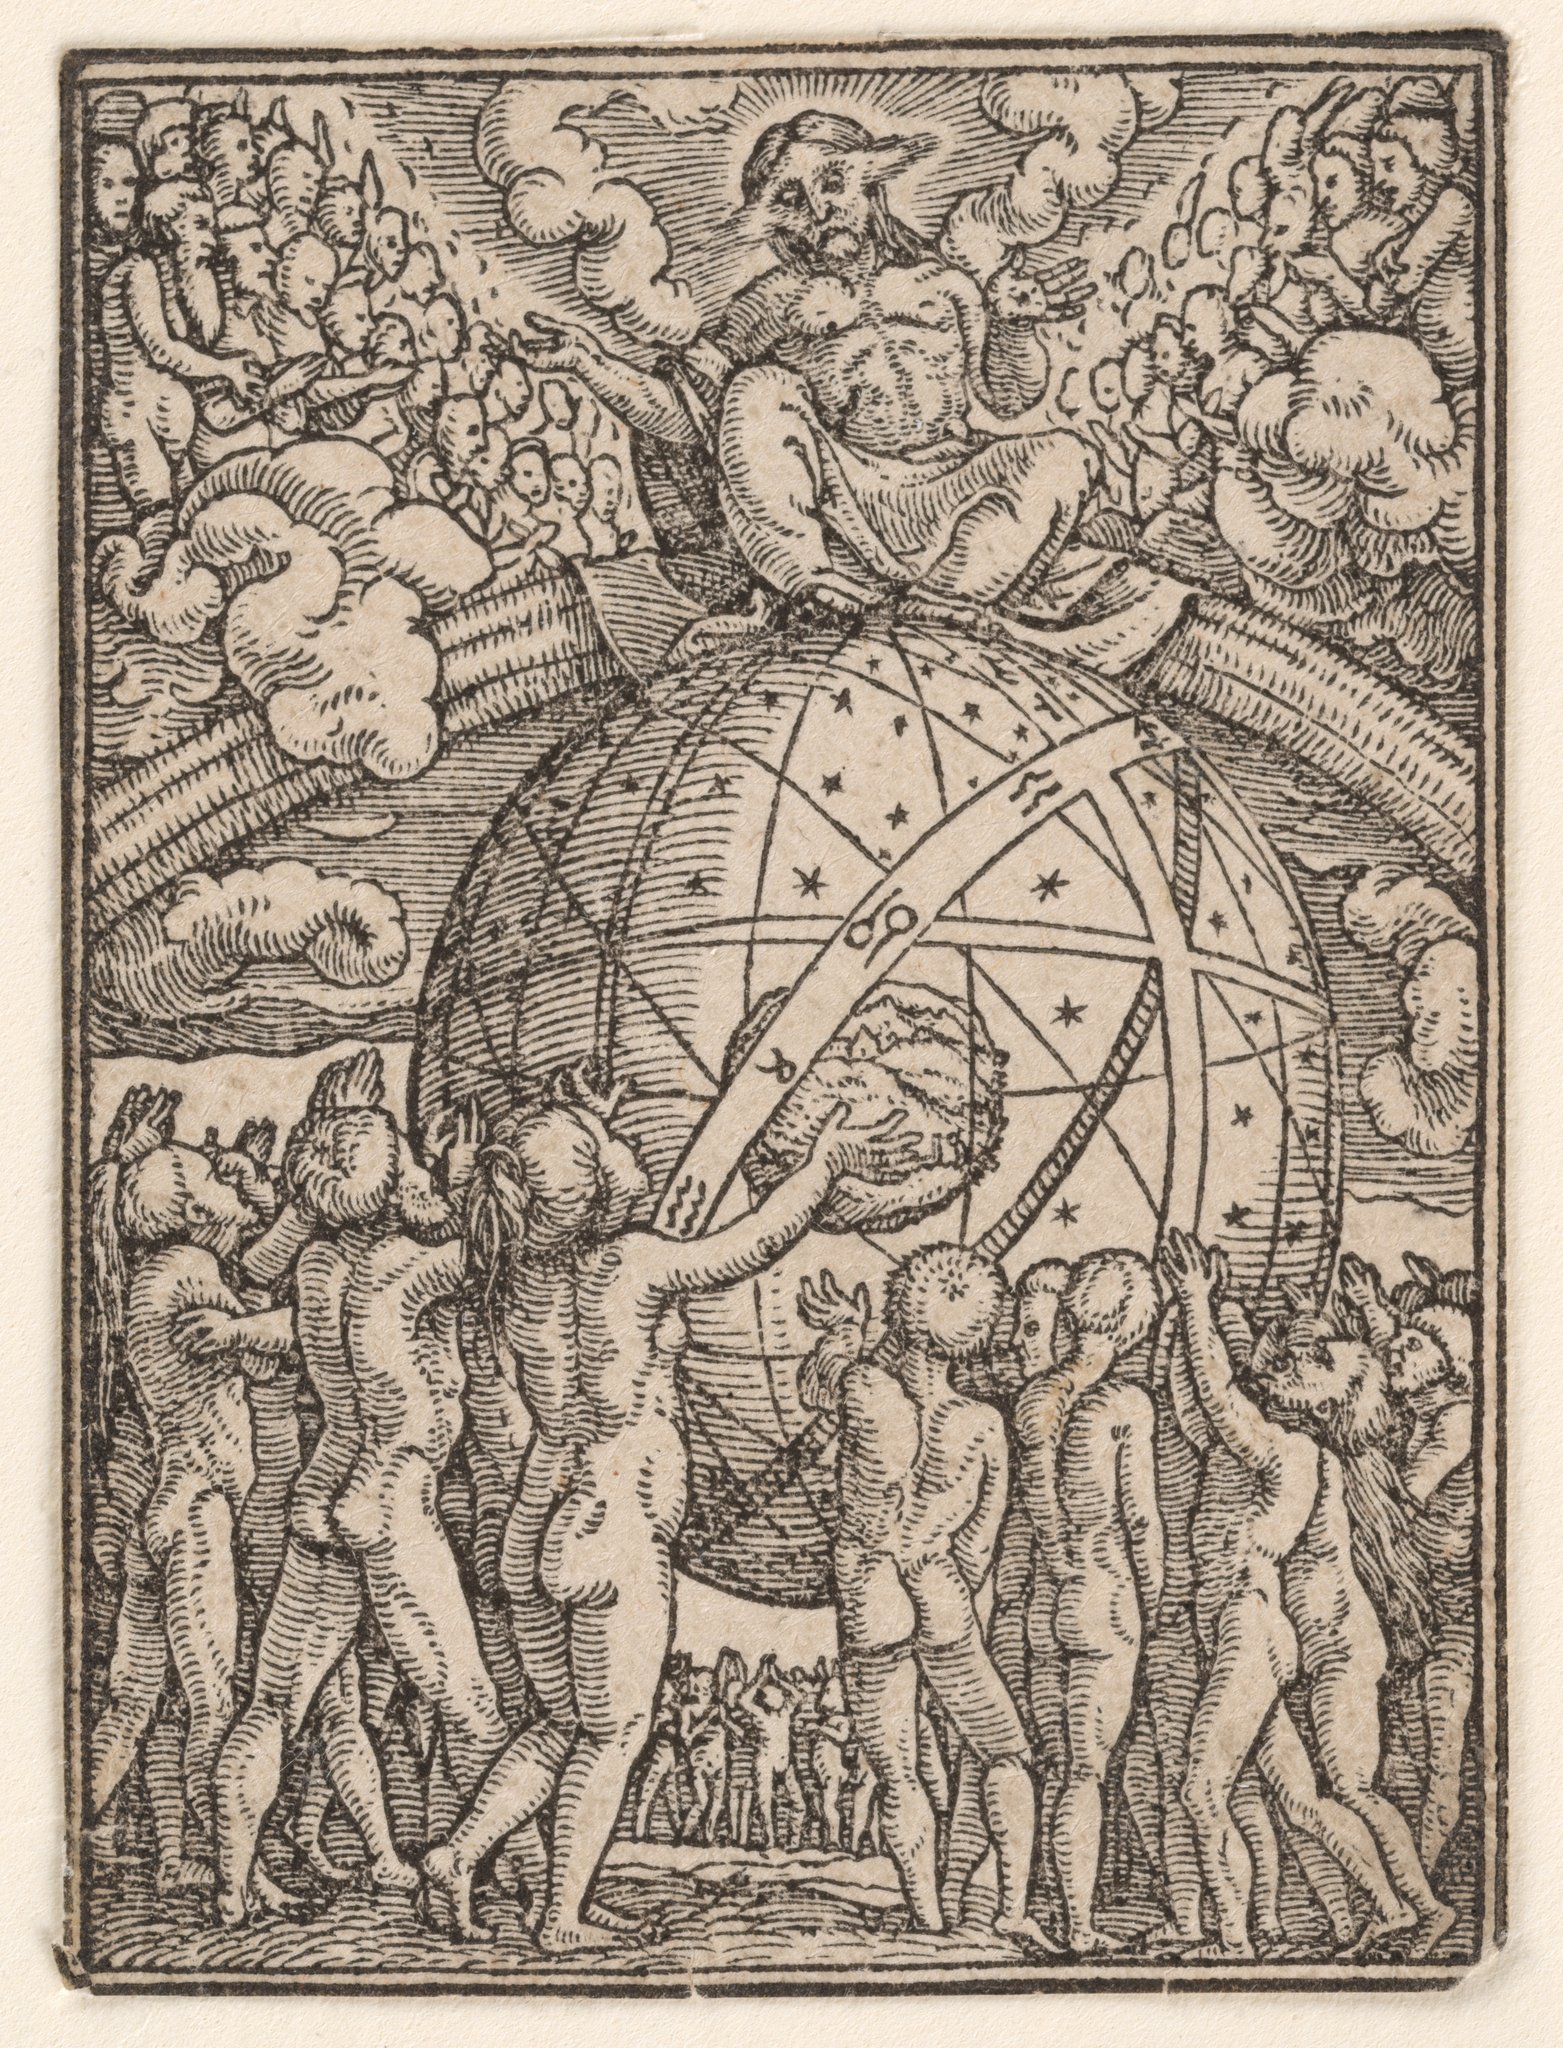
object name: print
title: The Last Judgment, from "The Dance of Death"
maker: hans holbein the younger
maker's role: artist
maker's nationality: german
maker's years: 1497-1543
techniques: woodcut